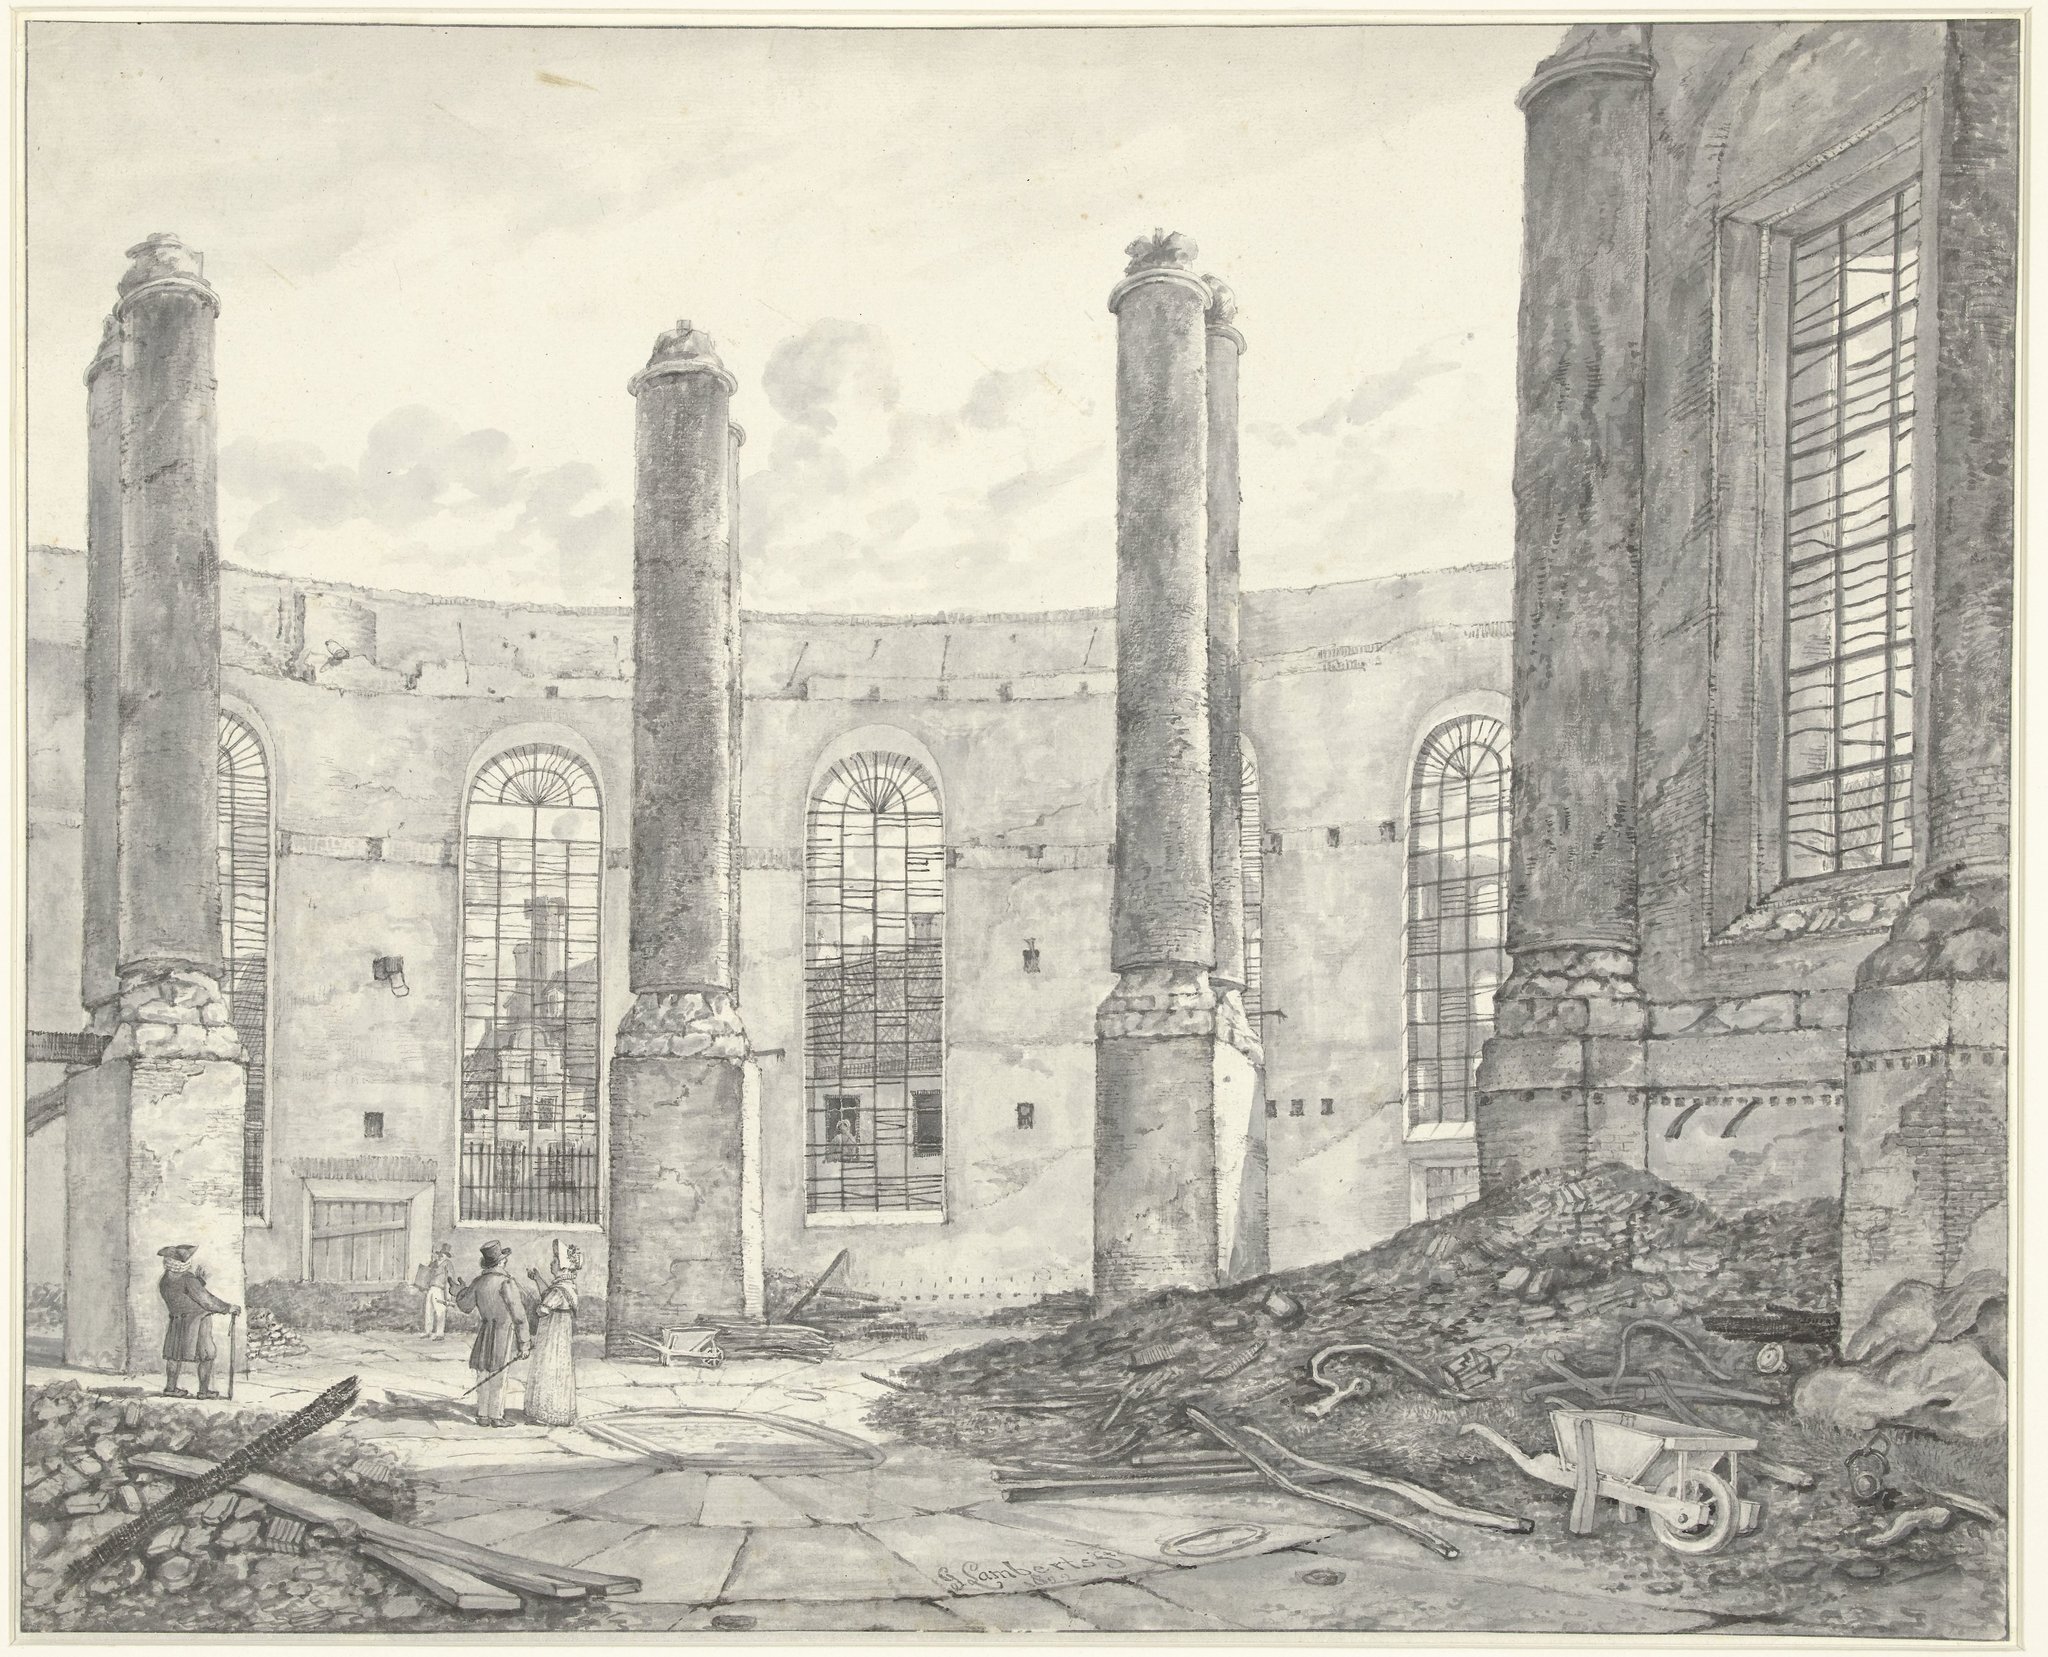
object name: drawing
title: Ruïne van de op 18 september 1822 verbrande Nieuwe Luthersche Kerk te Amsterdam, van de buitendeur naar binnen te zien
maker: gerrit lamberts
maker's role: bookseller, draughtsman, print maker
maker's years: 1776-1850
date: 1822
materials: chalk, ink, paper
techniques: brush, pen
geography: amsterdam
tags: on fire, ablaze, ruin of a building ~ architecture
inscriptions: signature and date: ‘G. Lamberts ft. 1822’